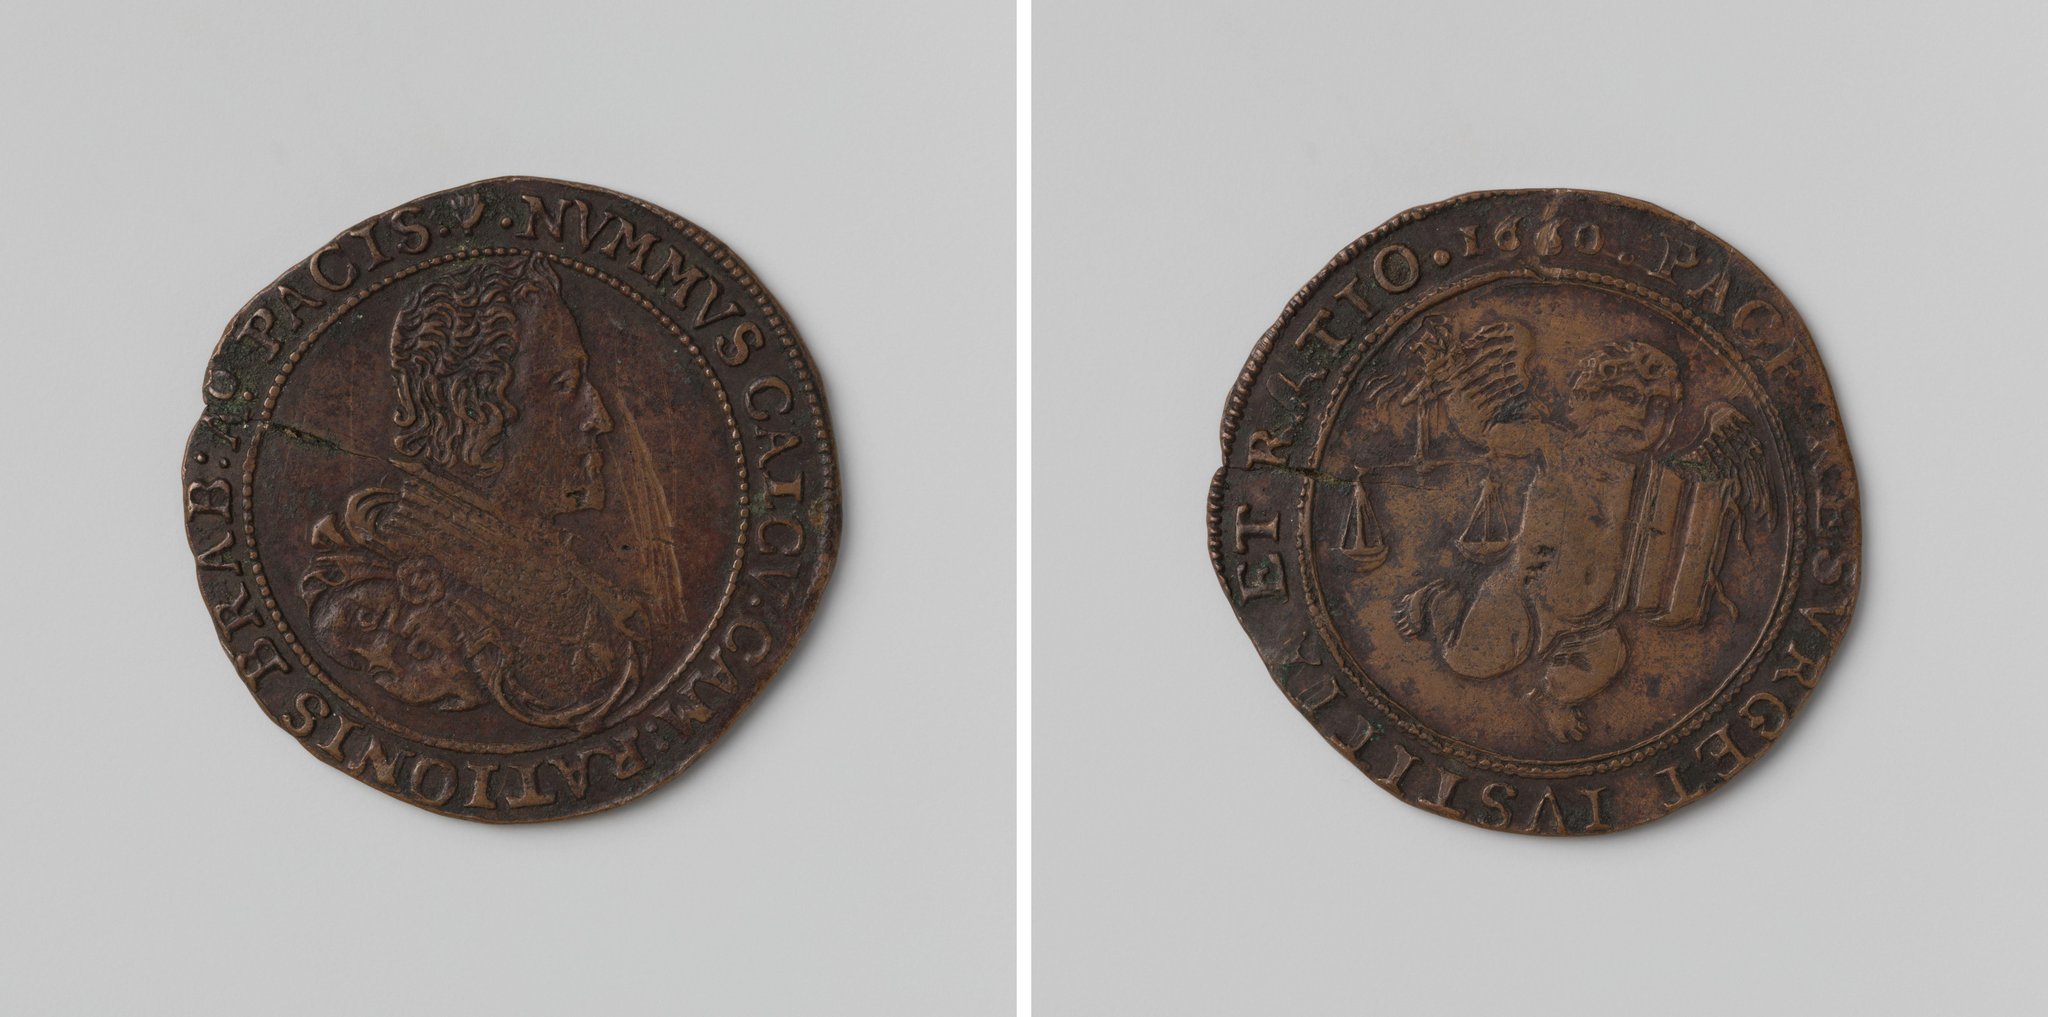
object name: jeton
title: Vrede van de Pyreneeën tussen Frankrijk en Spanje, rekenpenning geslagen op last van de rekenkamer van Brabant, ter ere van Filips IV, koning van Spanje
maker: Anonymous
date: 1660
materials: copper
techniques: striking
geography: antwerp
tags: filips iv (koning van spanje), france, spain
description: Koperen penning. Voorzijde: borststuk man binnen omschrift. Keerzijde: vliegende genius met geopend boek in linker- en weegschaal in rechterhand binnen omschrift